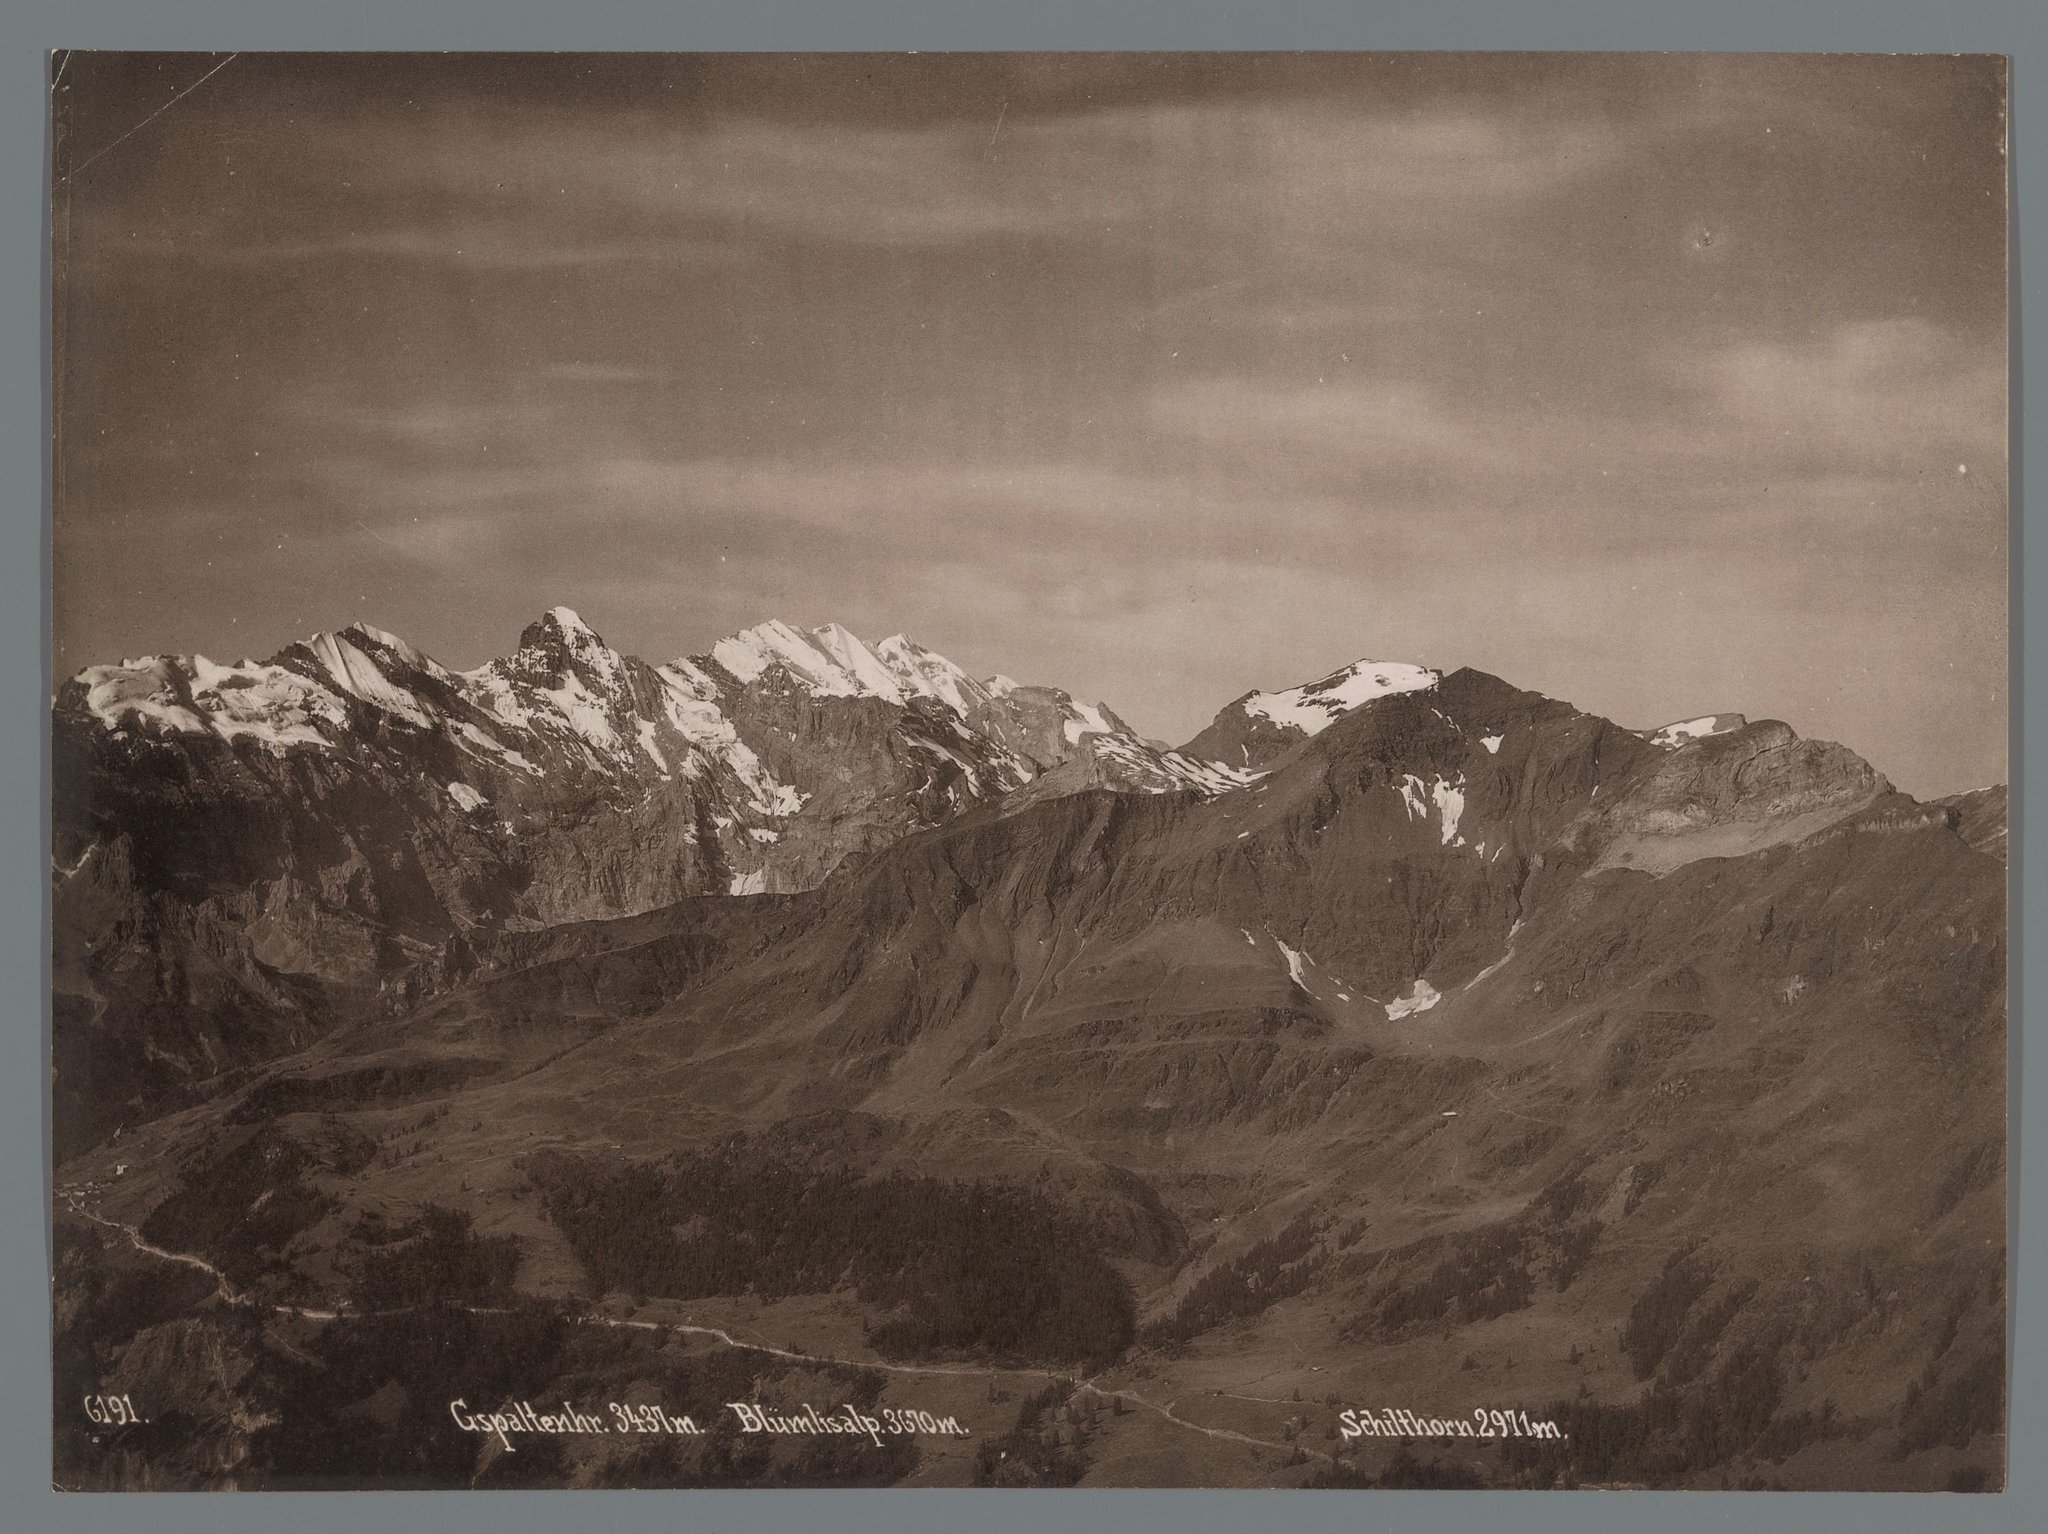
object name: photomechanical print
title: Gezicht op de Gspaltenhorn, de Blüemlisalp en de Schilthorn in de Berner Alpen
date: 1870-1889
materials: paper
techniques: photograph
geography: berner alpen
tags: mountains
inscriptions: number: ‘6191.’, collector's mark: ‘VOSMAER’, inscription: ‘Gspaltenhr. 3437m. Blümisalp. 3670m. Schilthorn. 2971m.’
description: Vormt samen met de gerelateerde objecten een panorama van de Berner Alpen.